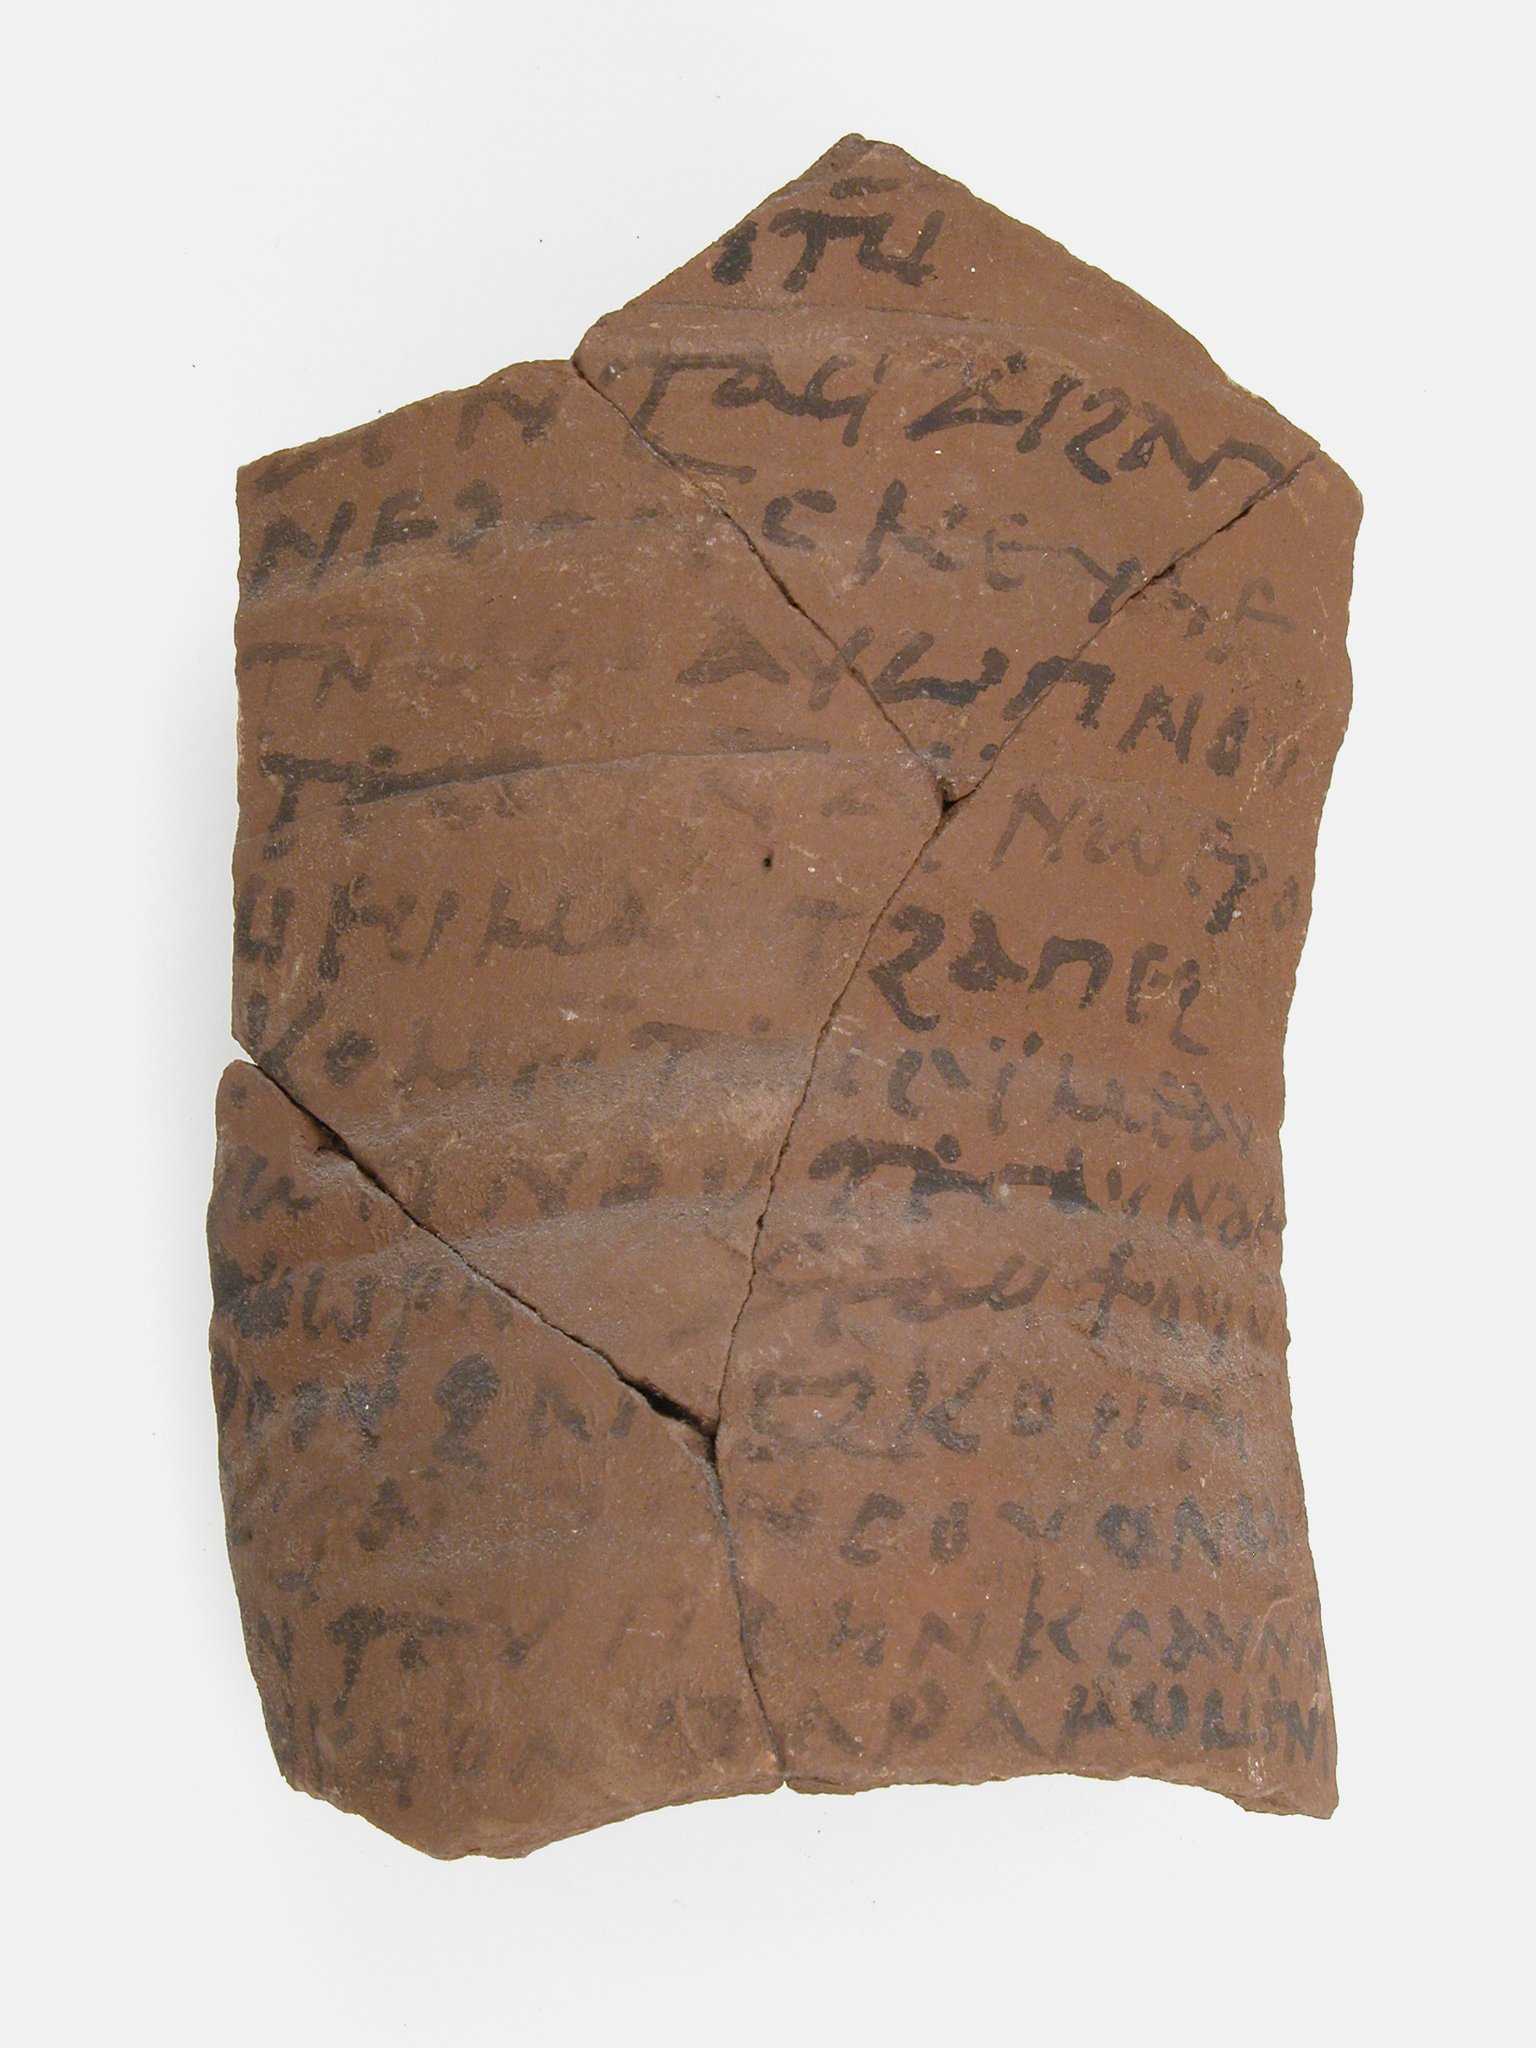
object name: ostrakon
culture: coptic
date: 601-700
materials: ink, pottery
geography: egypt